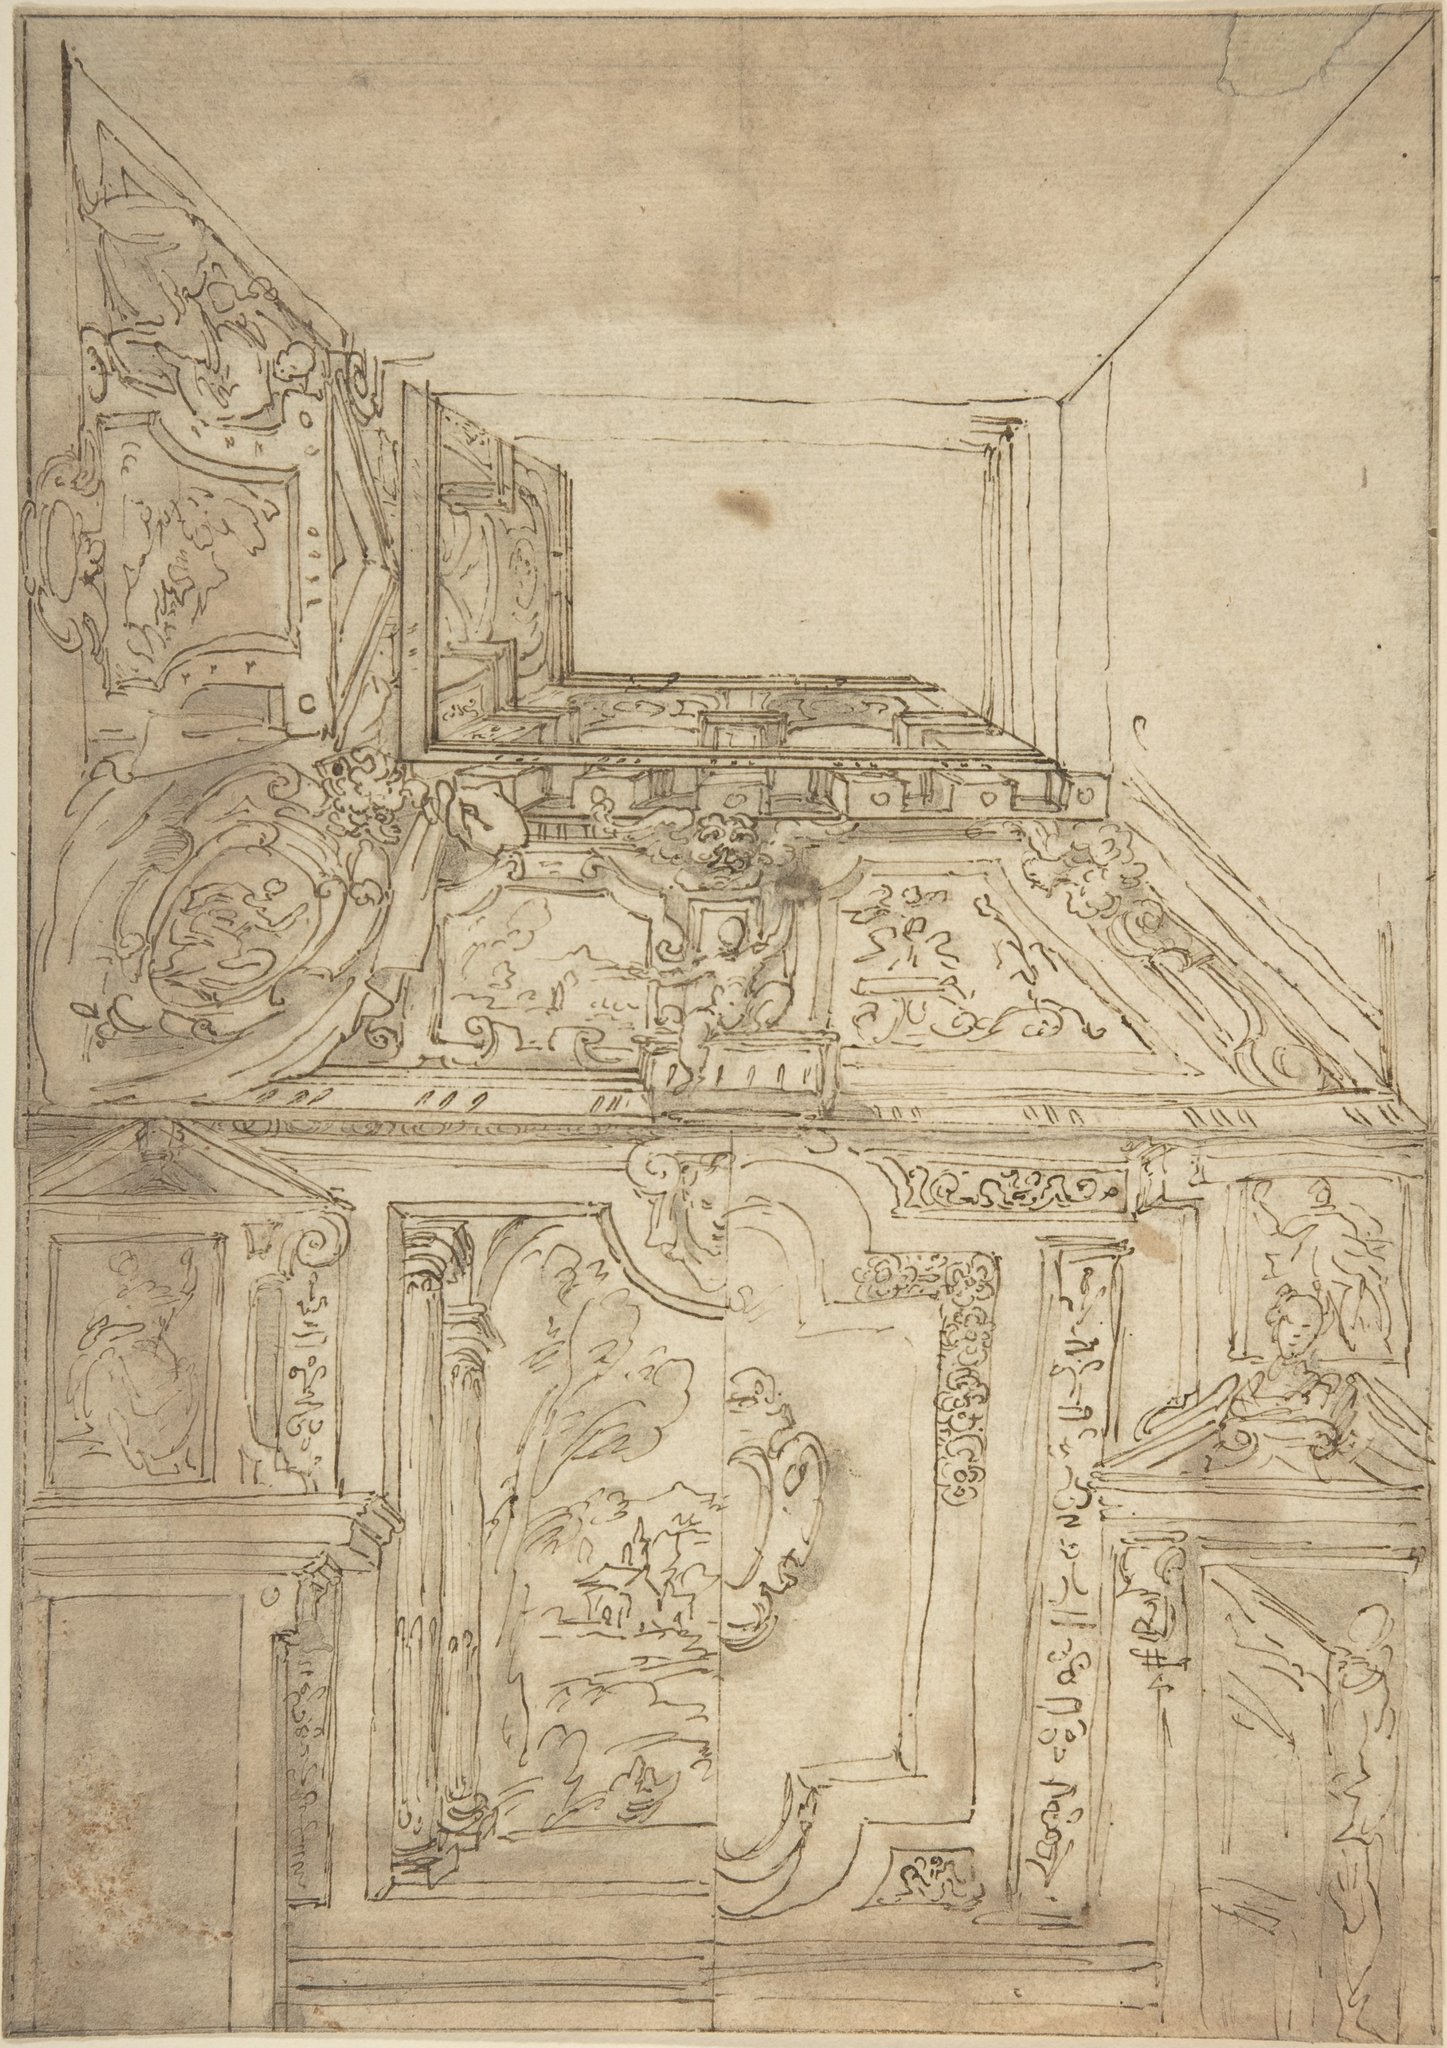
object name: drawing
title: Study for a Vault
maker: anonymous, italian, 17th century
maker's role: artist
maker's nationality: italian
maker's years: 1600-1700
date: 1601-1700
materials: chalk, ink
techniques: brush, pen, wash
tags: architecture